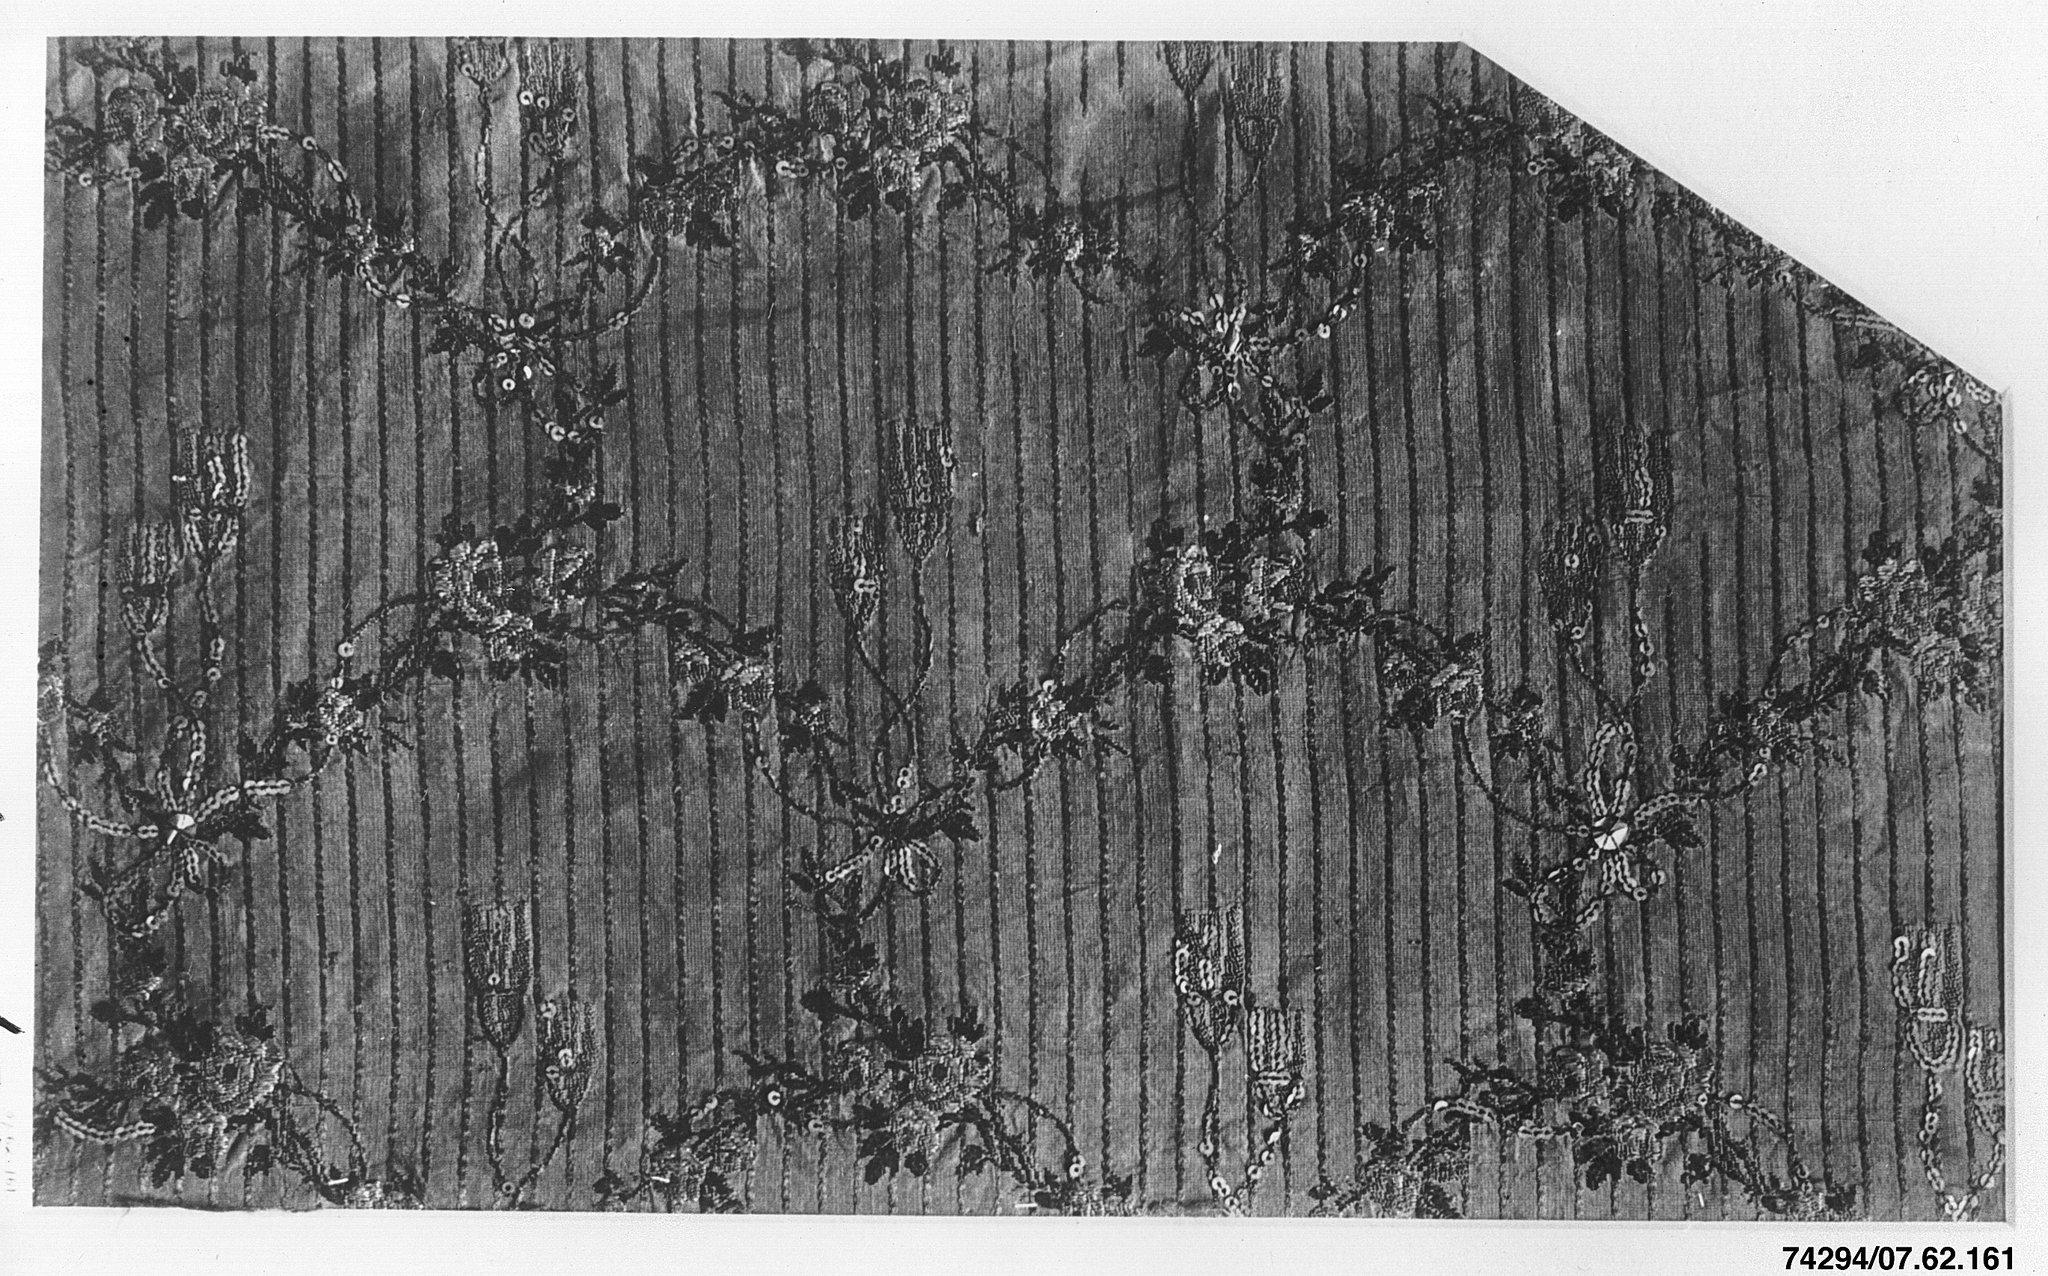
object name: fragment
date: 1774-1793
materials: metal thread, silk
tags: flowers,leaves